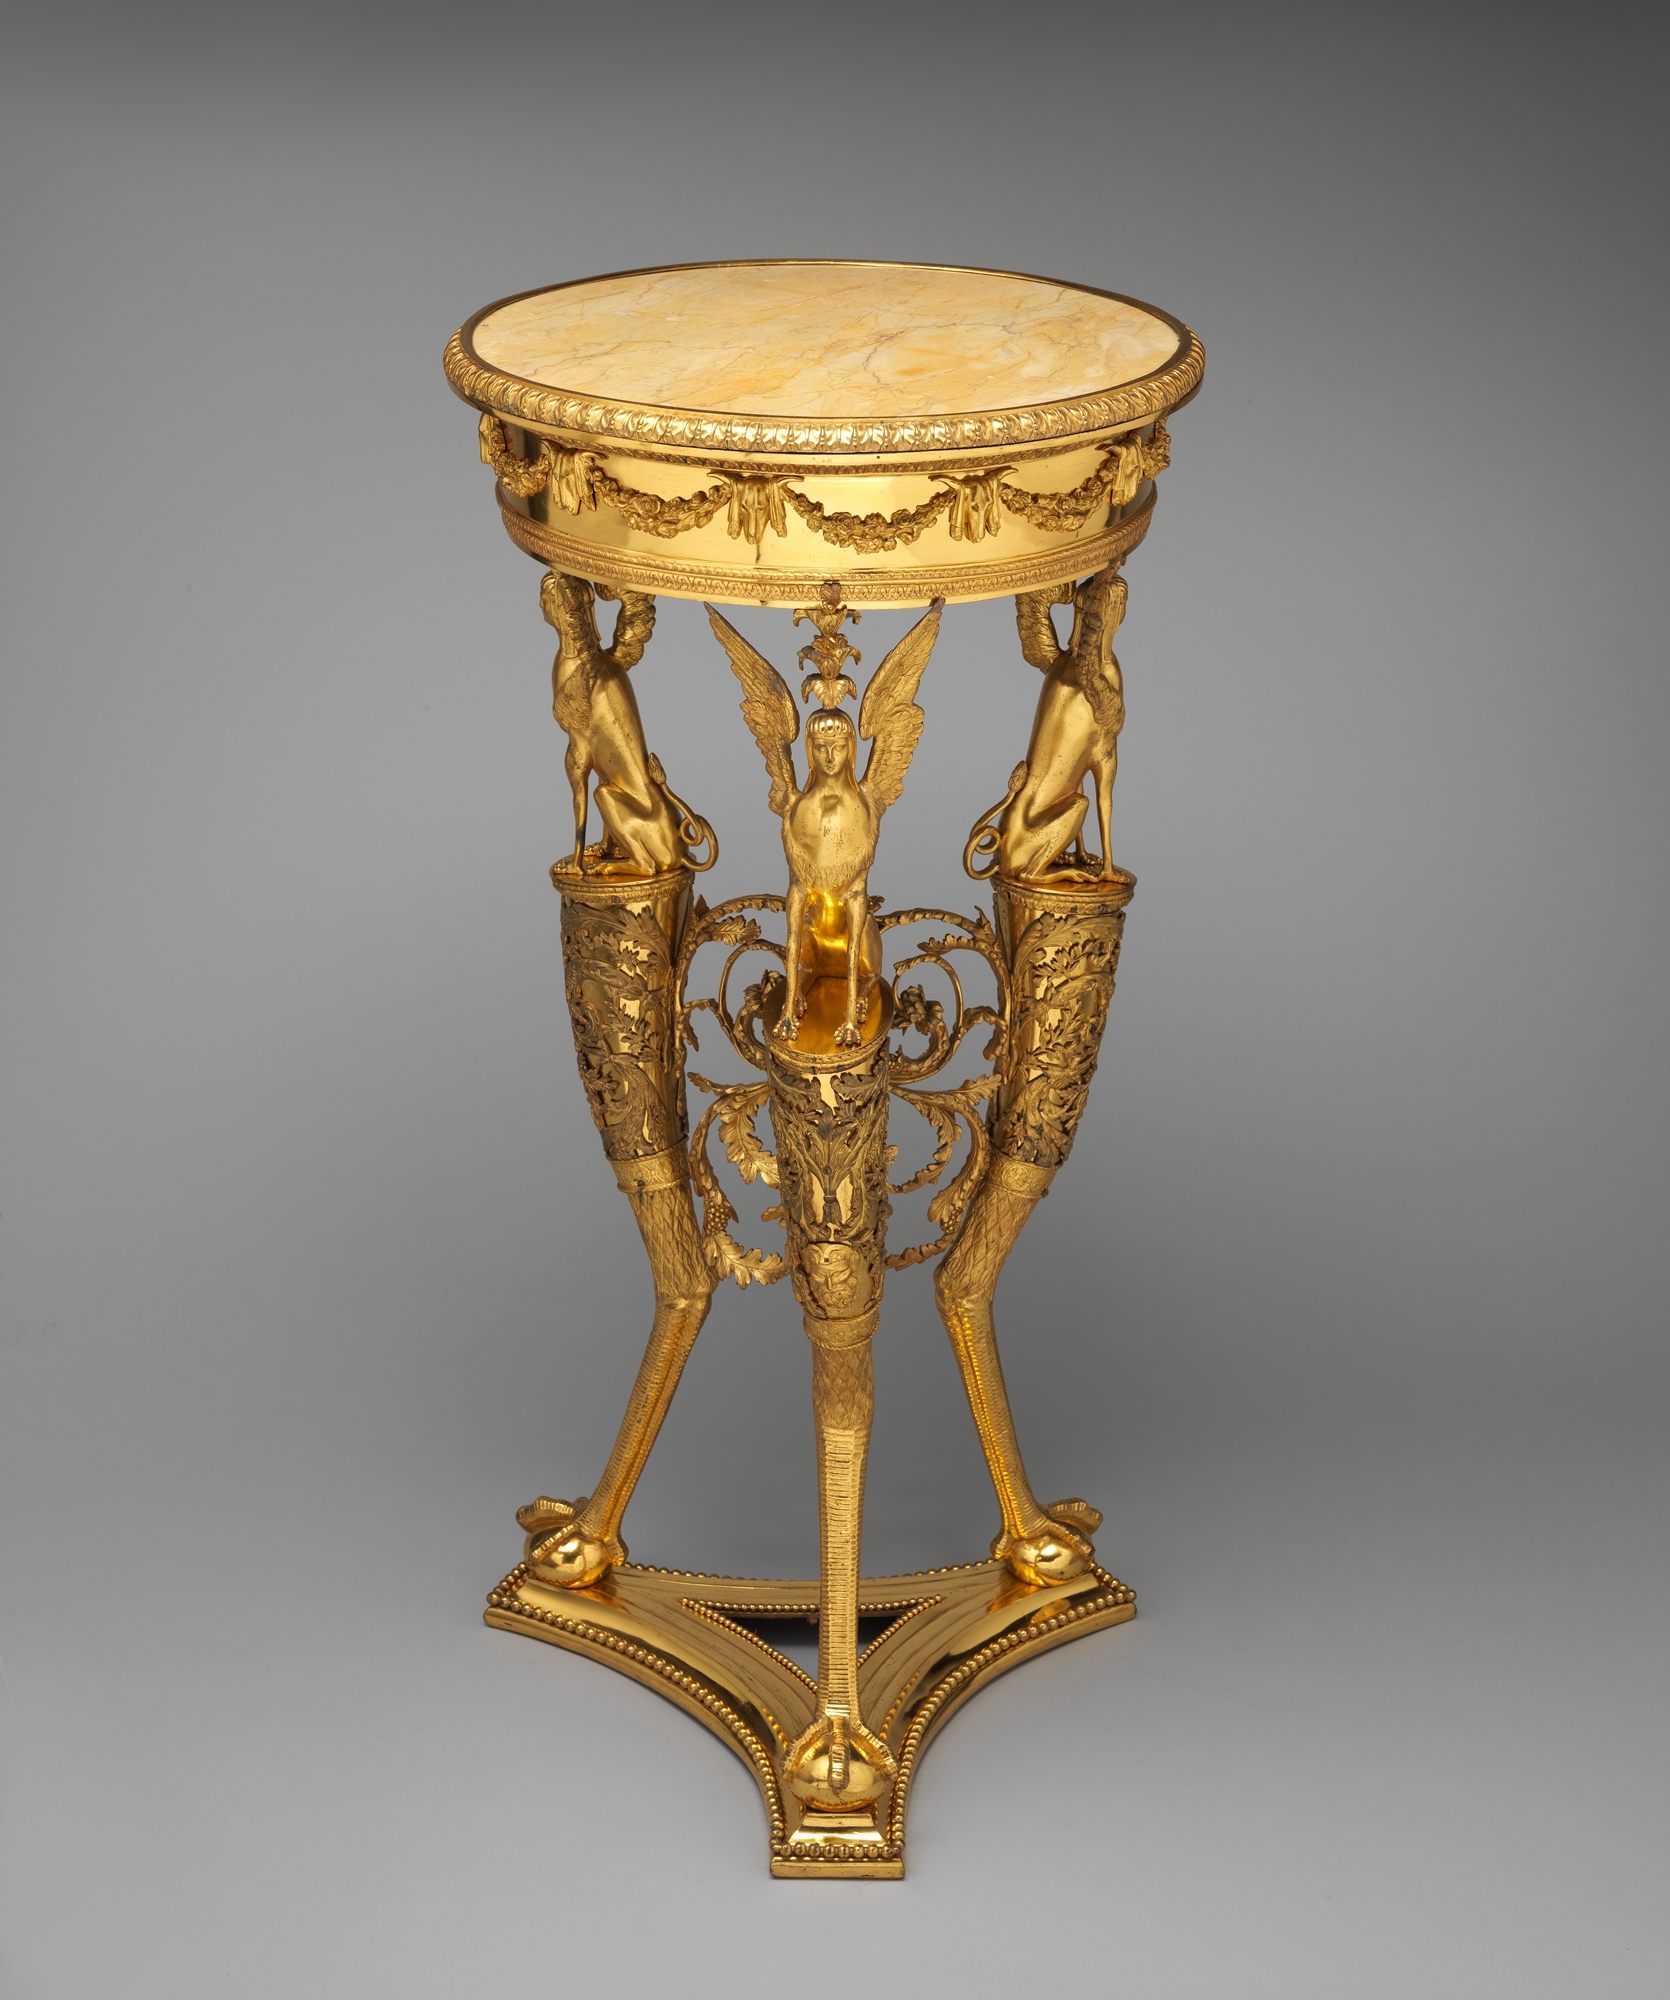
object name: table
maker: pierre antoine bellangé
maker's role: maker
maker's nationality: french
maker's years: 1758-1827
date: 1801-1900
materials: copper, gilt, marble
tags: garlands,sphinx